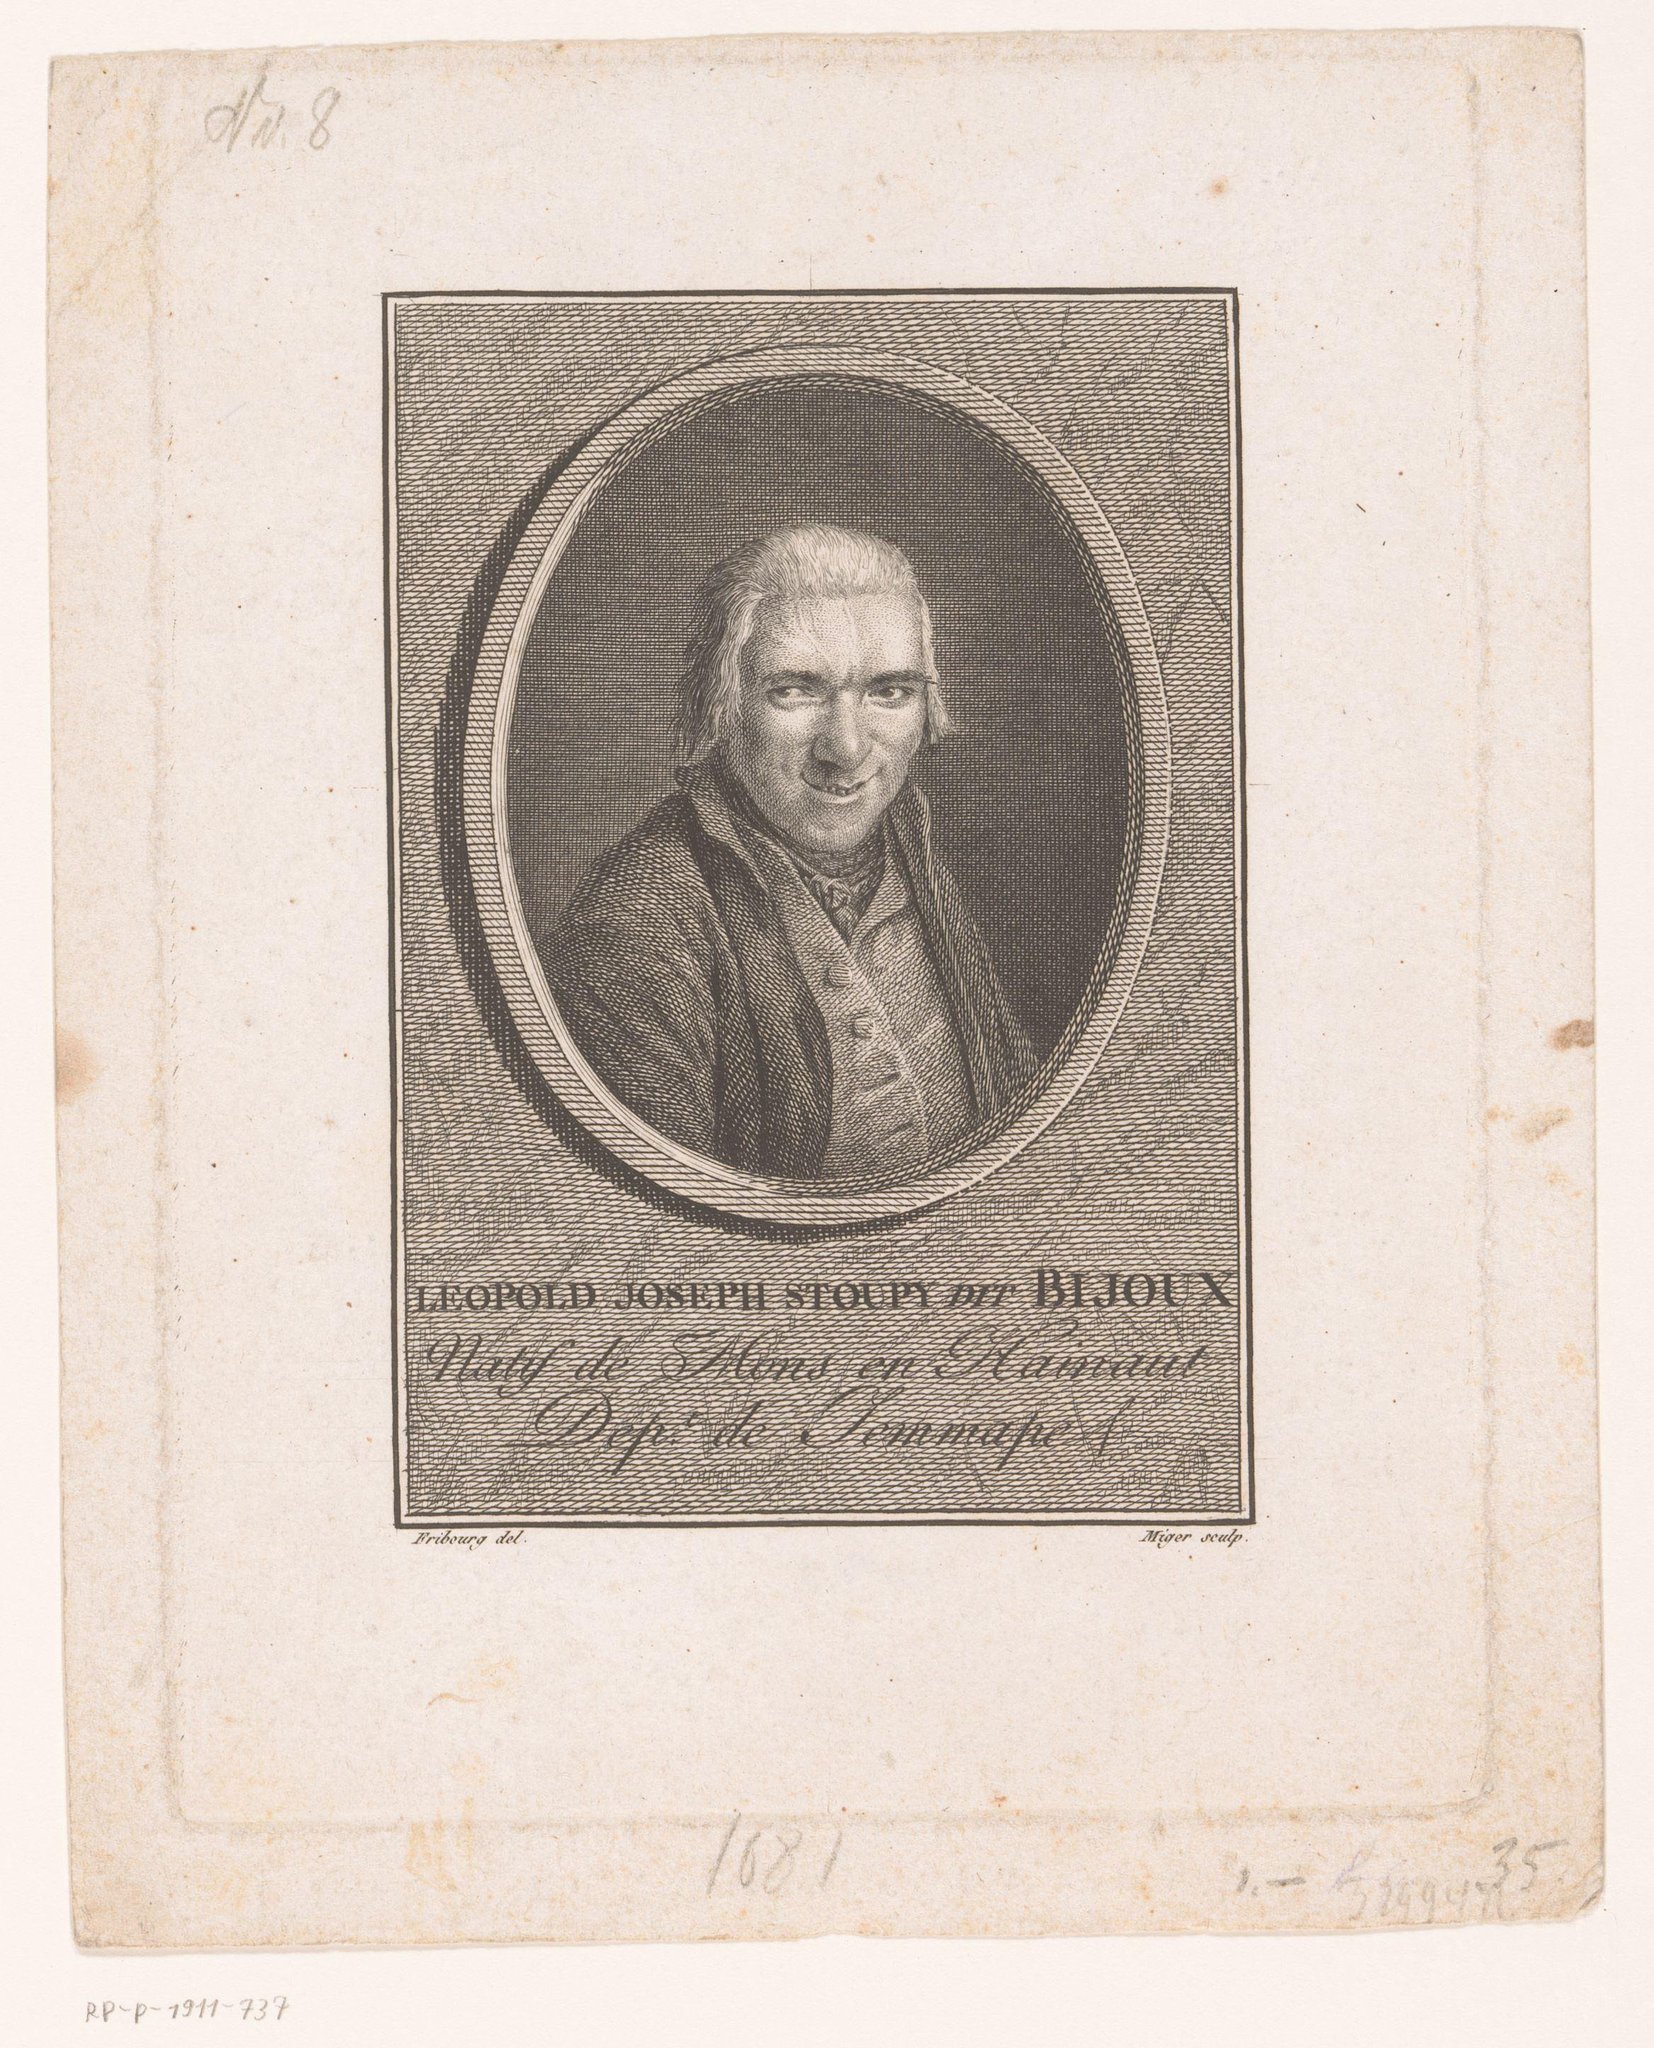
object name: print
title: Portret van Leopold Joseph Stoupy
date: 1746-1820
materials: paper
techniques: engraving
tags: historical persons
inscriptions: collector's mark: Lugt 2228, number: ‘n. 9’